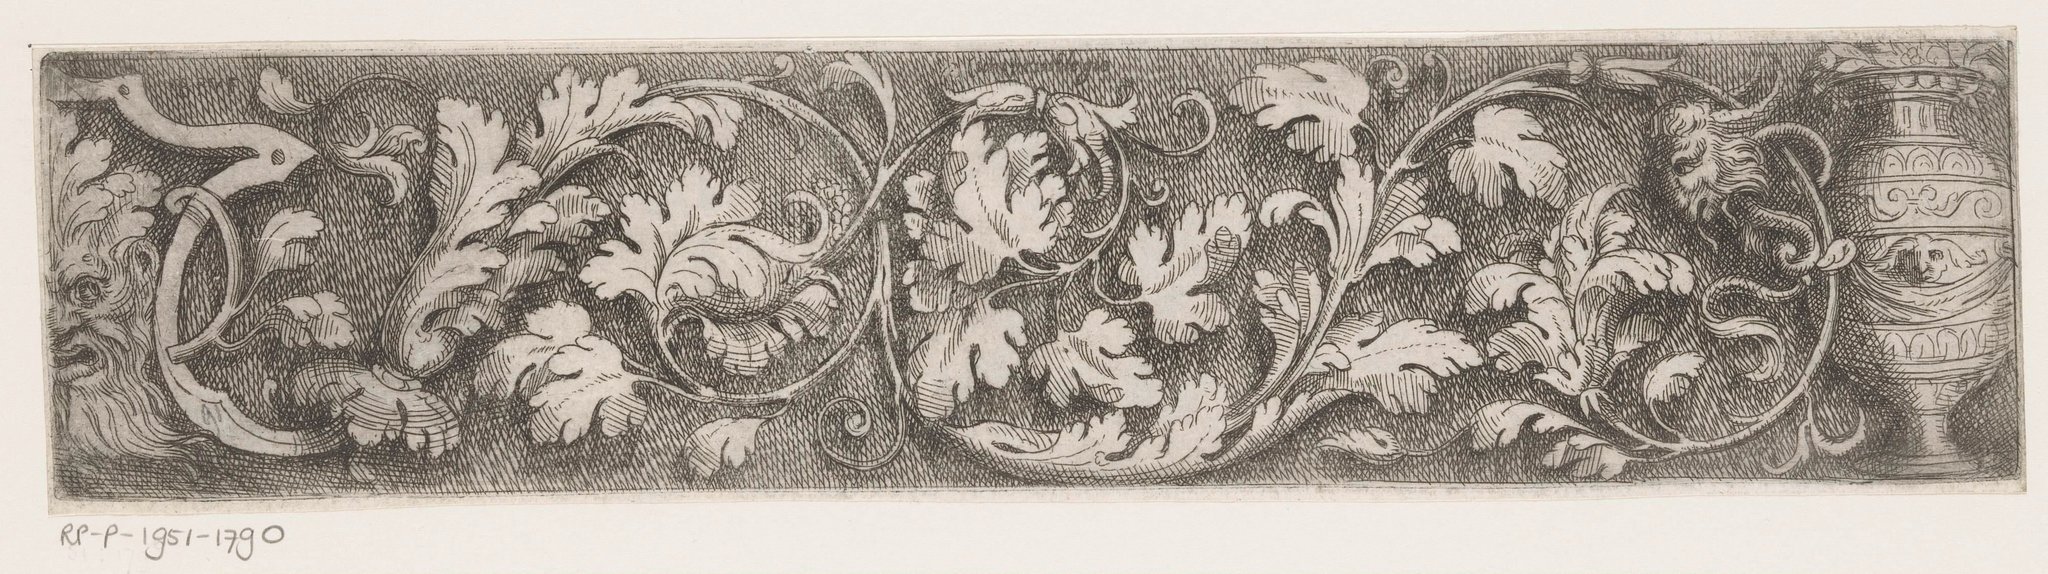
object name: print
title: Fries met arabesken, een masker en een vaas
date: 1561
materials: paper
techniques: etching, intaglio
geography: venice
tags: ornaments ~ art, foliage ~ ornament, vase ~ ornament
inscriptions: collector's mark: Lugt 2228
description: Deze prent maakt onderdeel uit van een reeks.